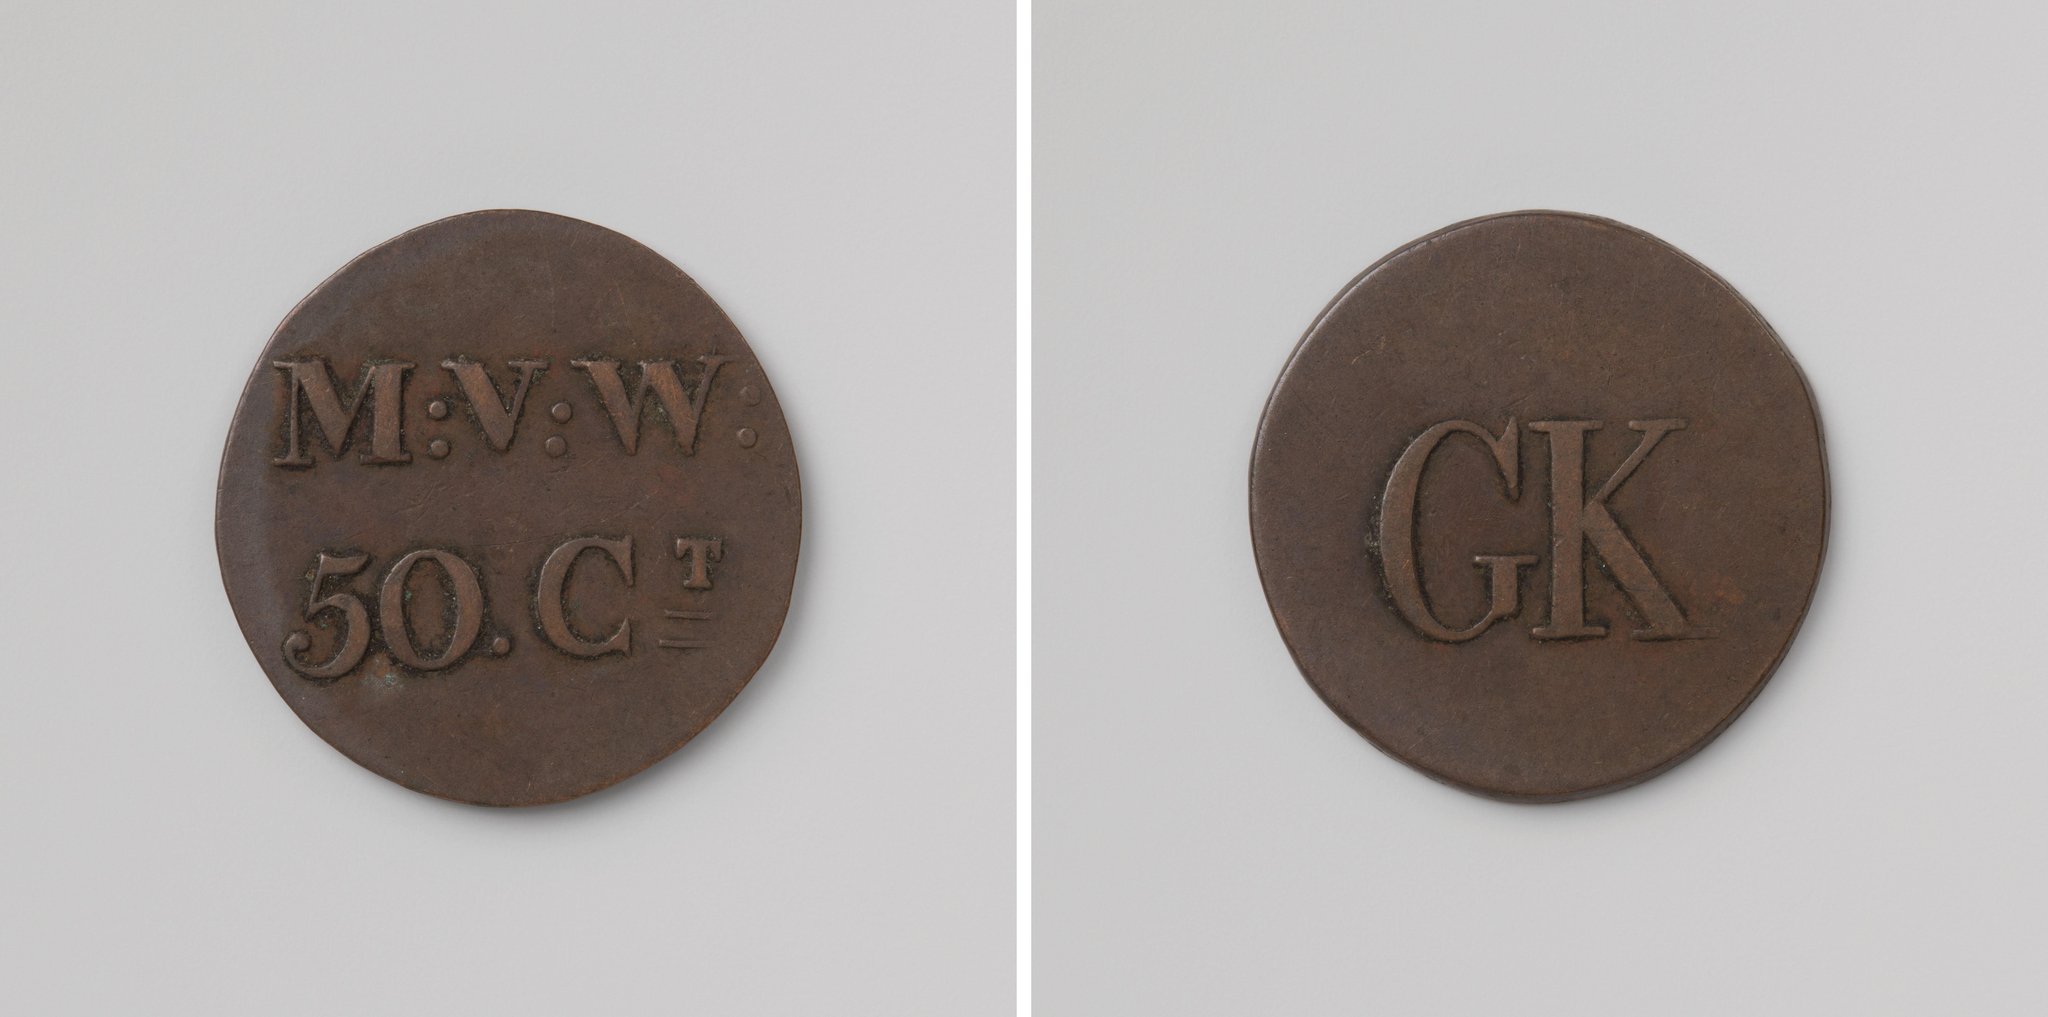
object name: vijftig cent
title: Huismunt geslagen op last van de Maatschappij van Weldadigheid ter waarde van 50 cent, ten behoeve van de Gewone Koloniën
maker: Anonymous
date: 1818-1859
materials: copper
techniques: striking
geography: netherlands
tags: maatschappij van weldadigheid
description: Voorzijde: opschrift boven waardeaanduiding. Keerzijde: opschrift G en K